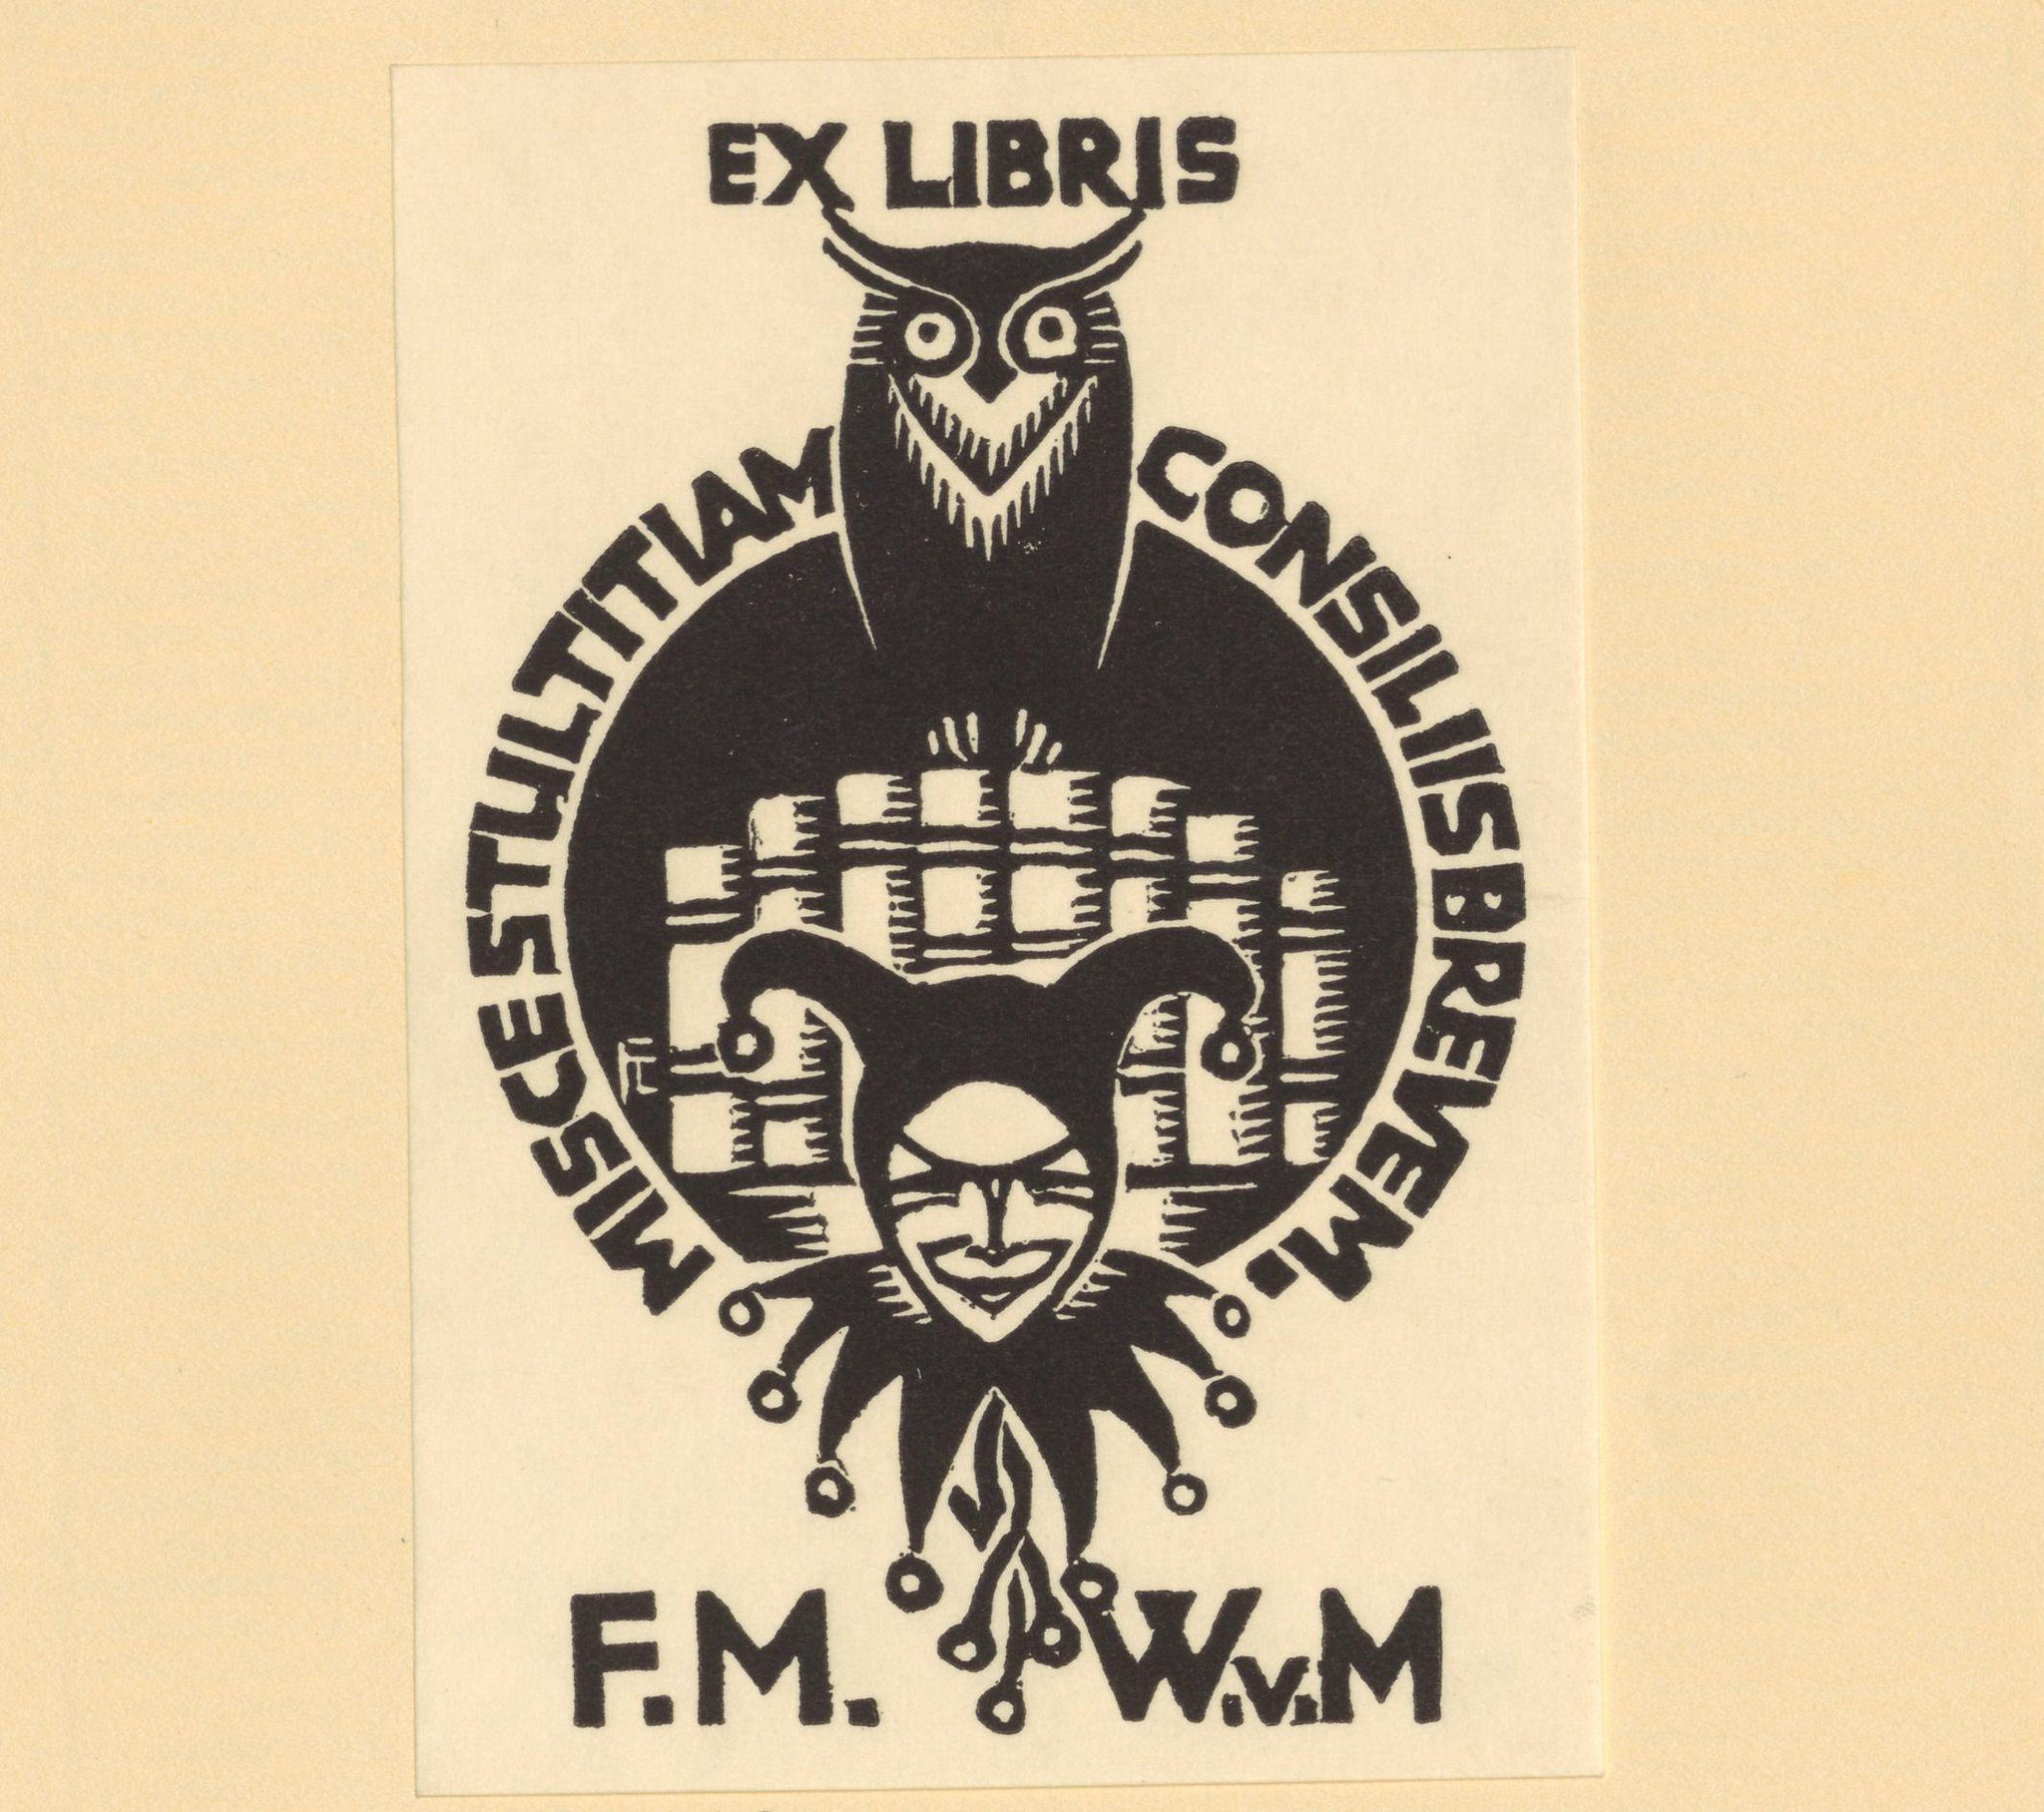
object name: bookplate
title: F.M.W.v.M.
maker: fré cohen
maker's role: draughtsman, print maker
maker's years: 1903-1943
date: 1935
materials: paper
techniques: woodcut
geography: netherlands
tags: court jester, court fool, book, owls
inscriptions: inscription: ‘1935’